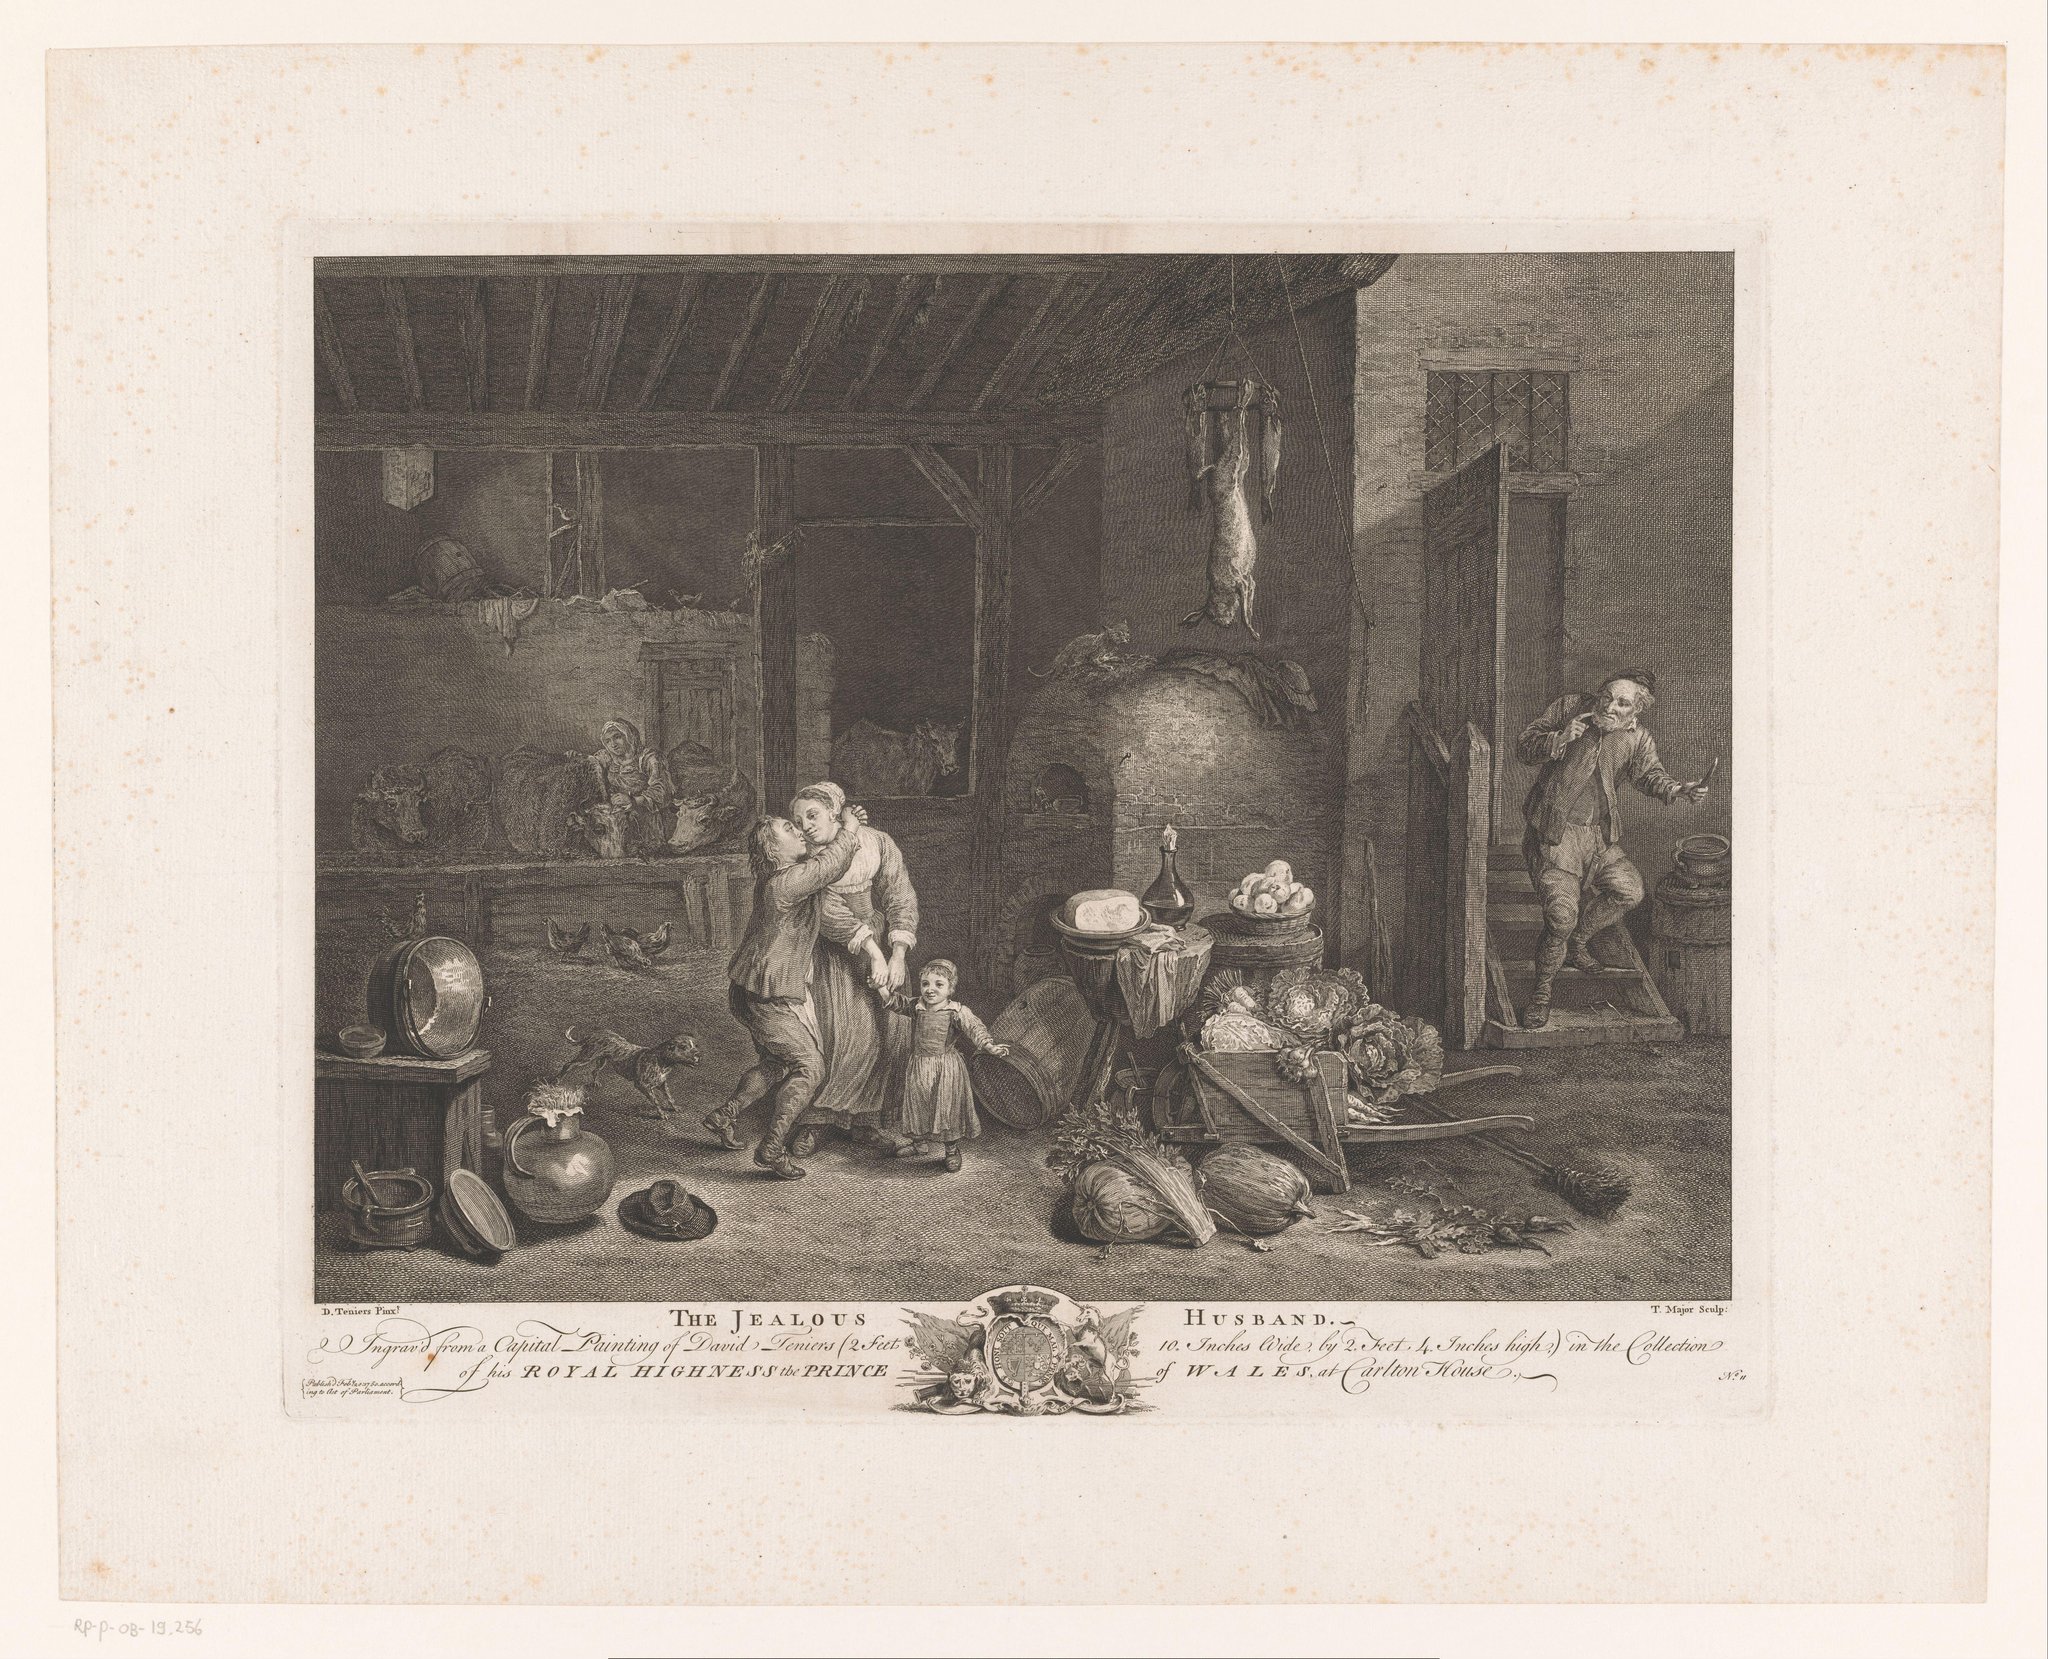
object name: print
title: Jaloerse echtgenoot ziet hoe zijn vrouw versierd wordt in de schuur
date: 1750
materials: paper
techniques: engraving, etching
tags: envy; 'invidia' (ripa) ~ personification of one of the seven deadly sins, lovers; courting, flirting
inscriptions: collector's mark: Lugt 240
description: Tekst in het Engels in de ondermarge. Genummerd: 11.